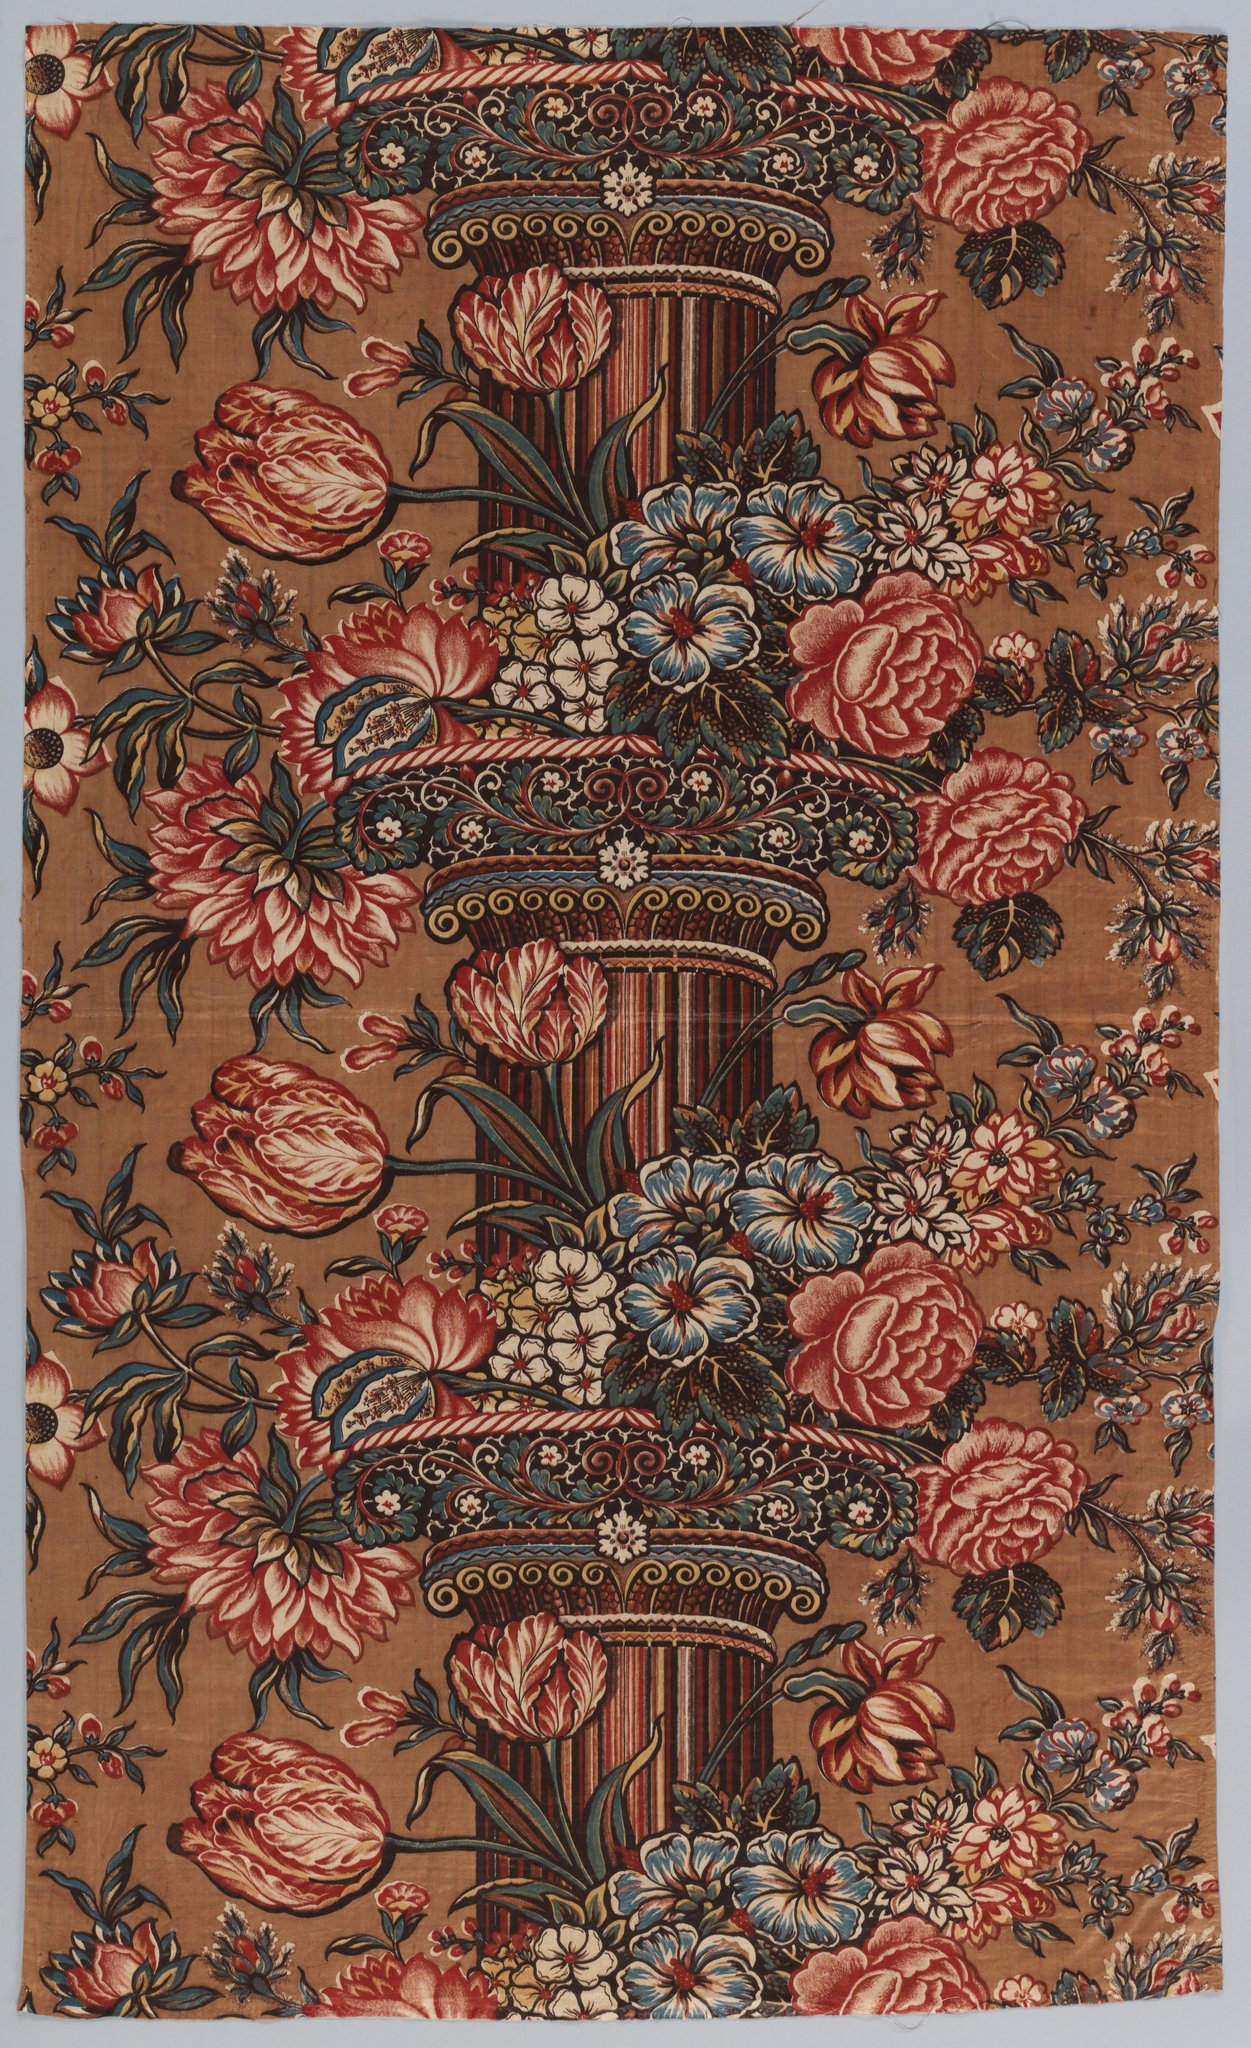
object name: piece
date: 1830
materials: cotton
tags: columns,flowers